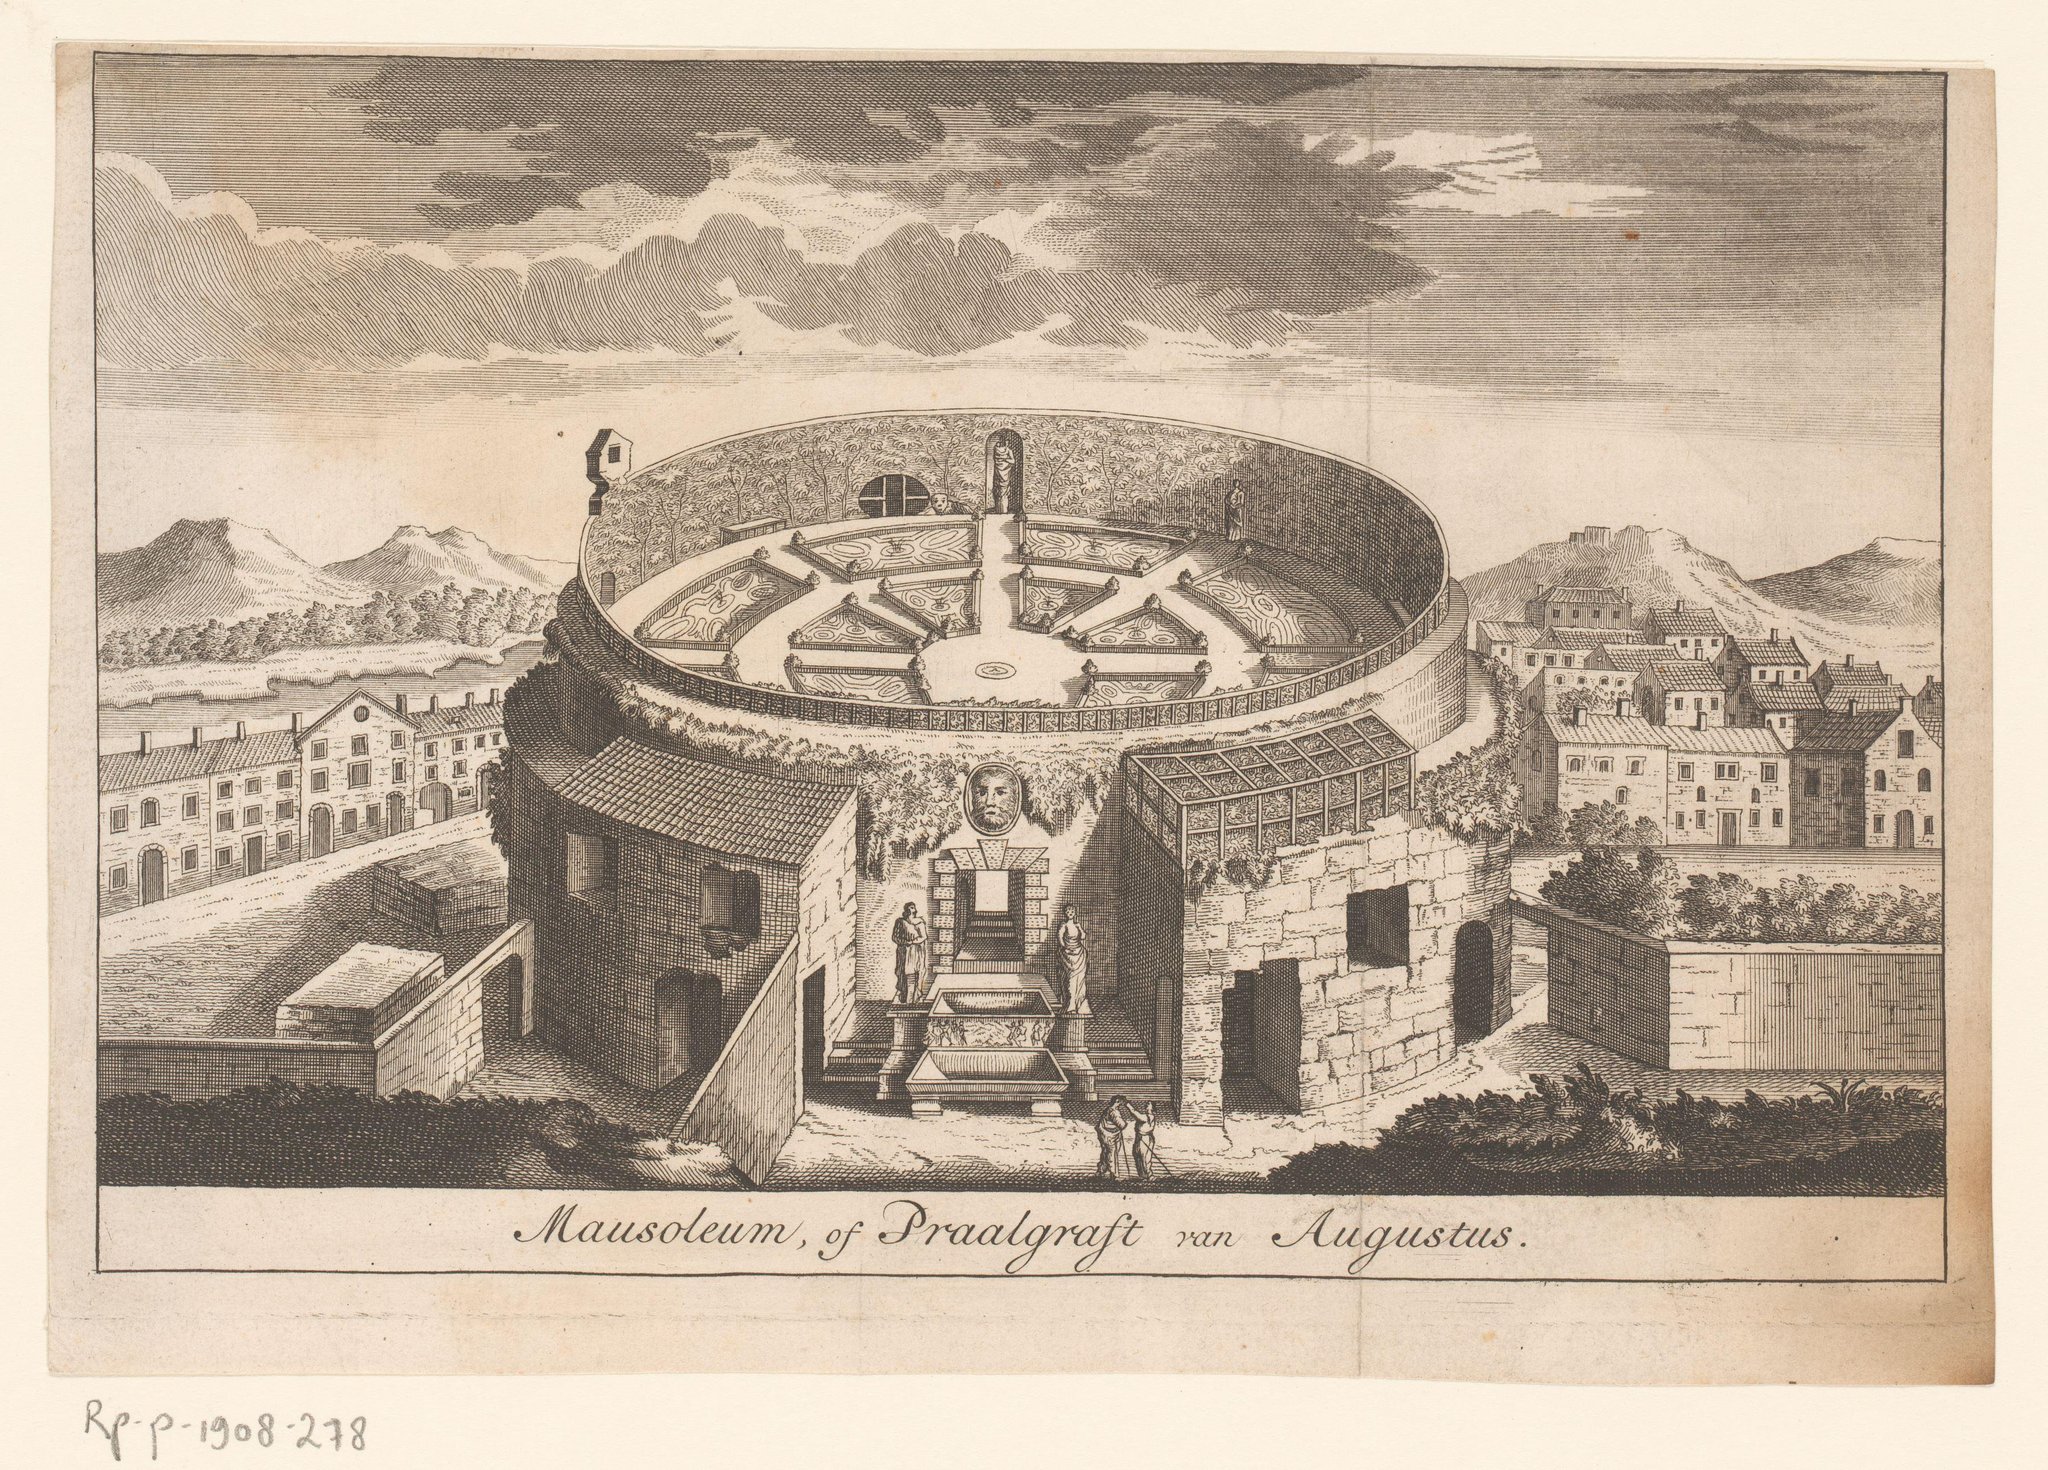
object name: print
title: Gezicht op het Mausoleum van Augustus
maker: Anonymous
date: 1600-1699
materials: paper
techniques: etching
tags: mausoleum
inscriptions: collector's mark: Lugt 2228